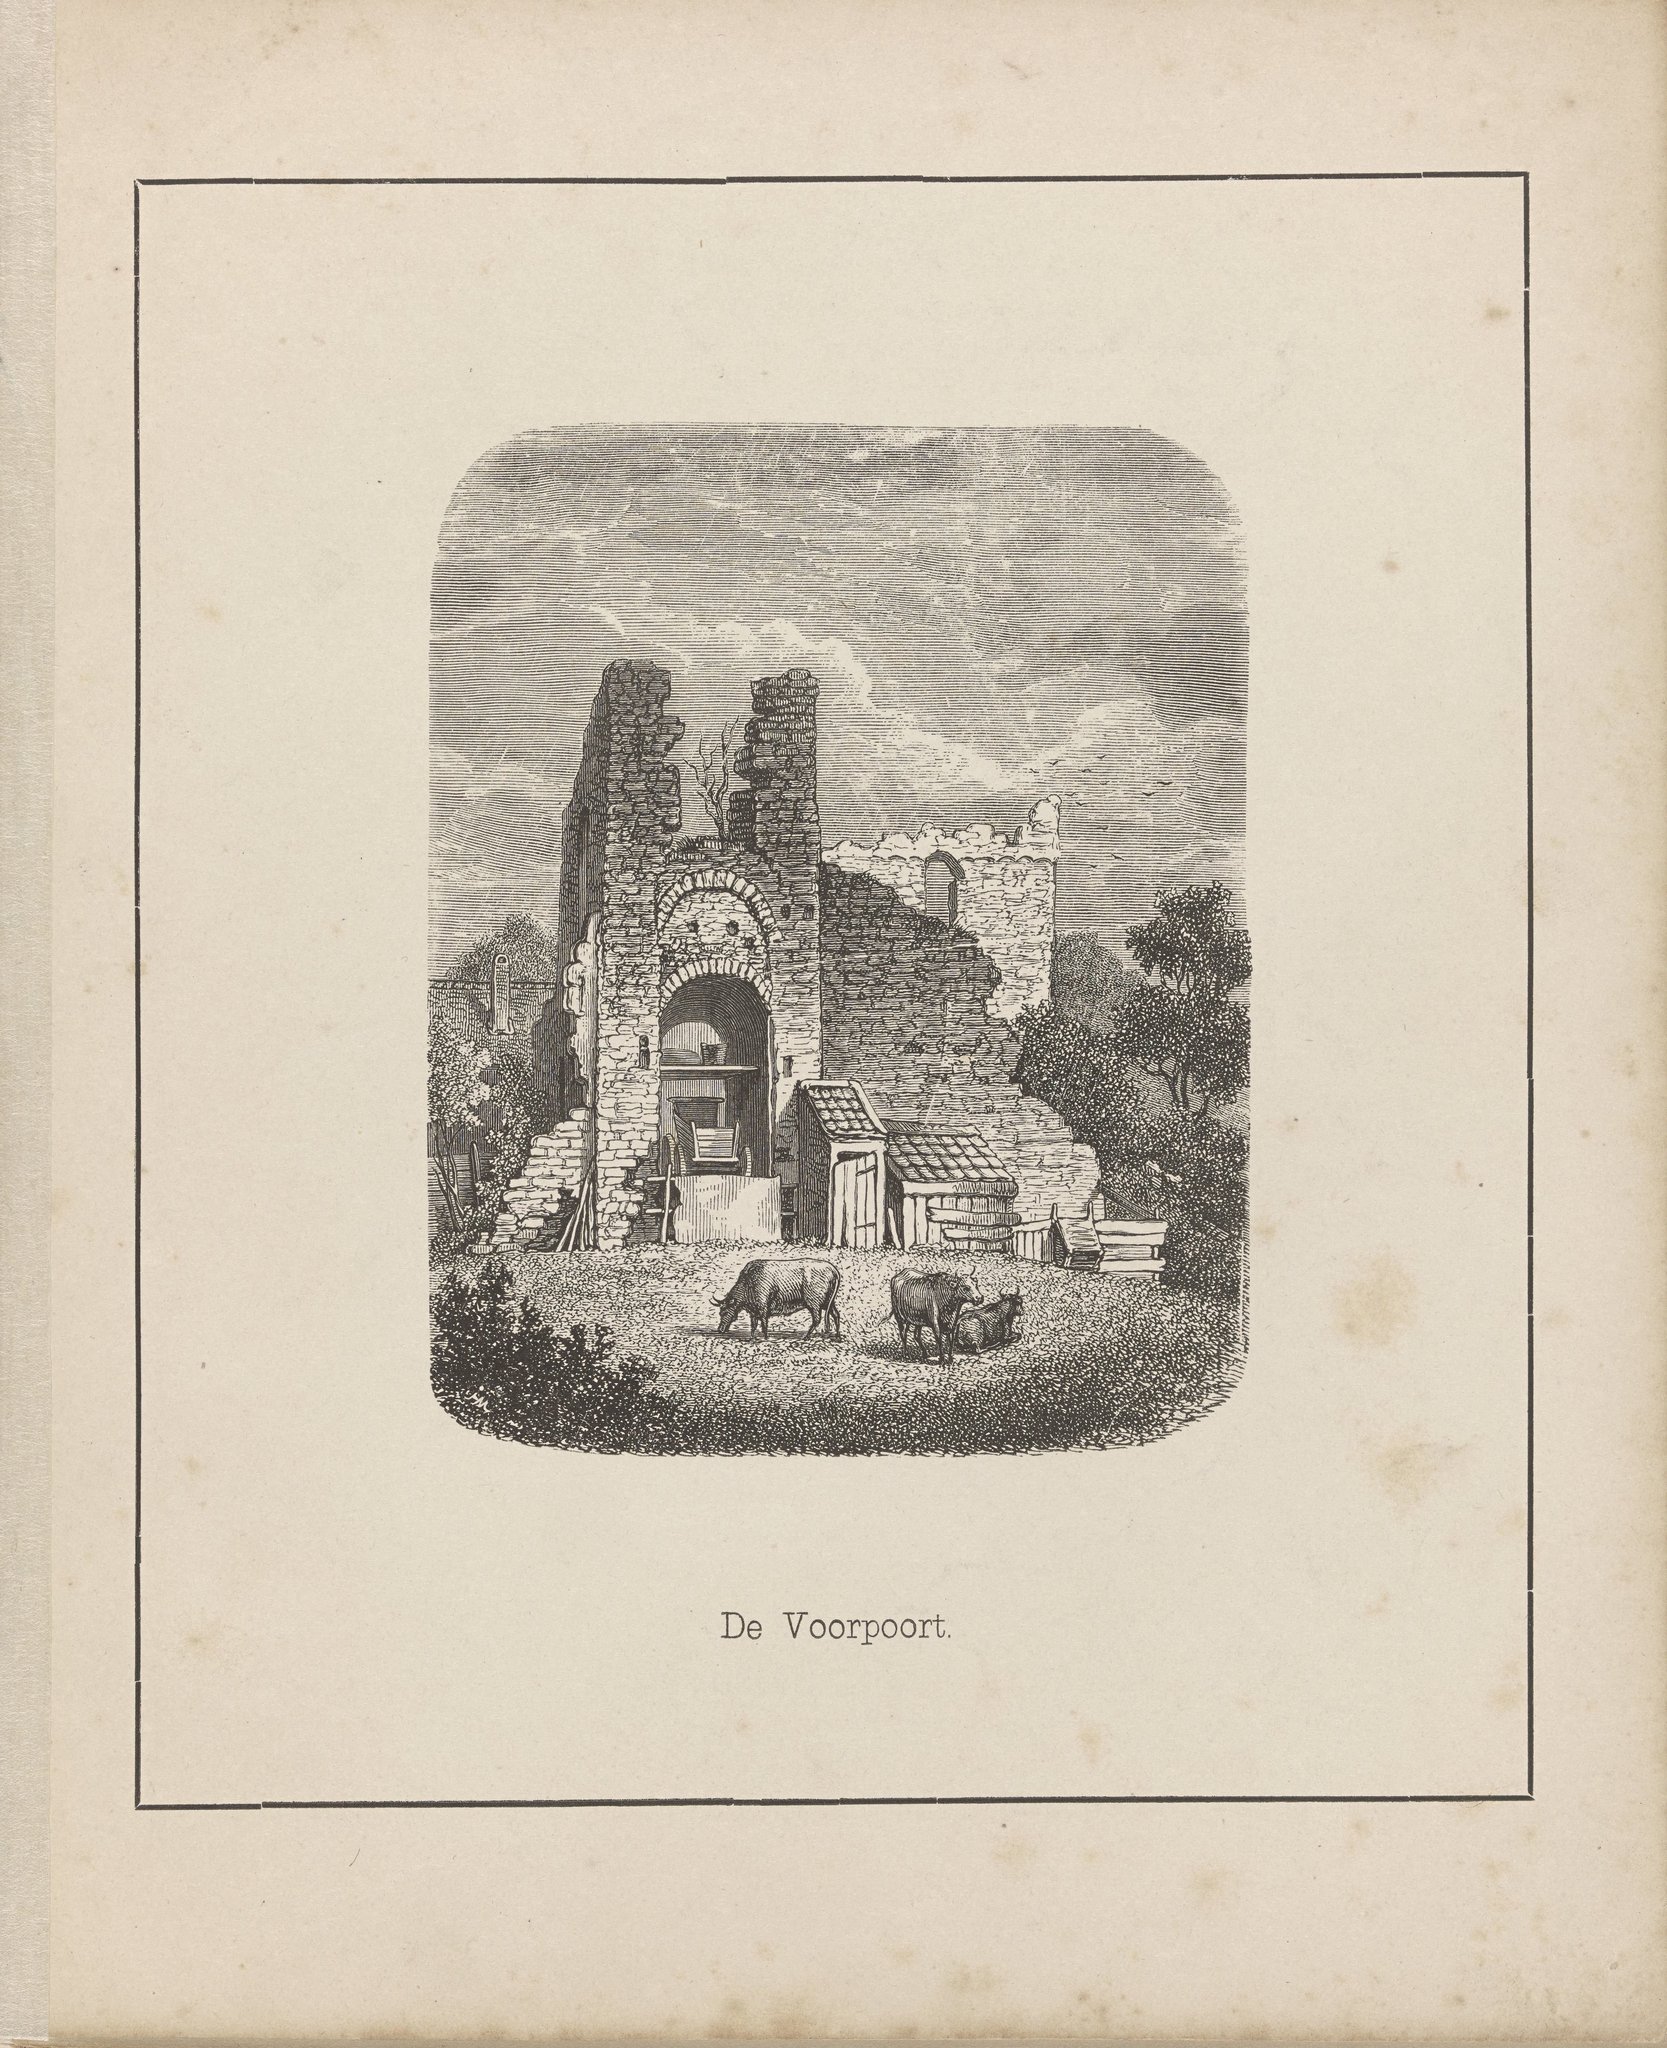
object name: book illustration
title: De voorpoort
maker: isaac weissenbruch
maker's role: print maker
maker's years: 1826-1912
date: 1861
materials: paper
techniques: letterpress printing, engraving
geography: amsterdam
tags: gate, entrance, ruin of a dwelling, house, castle, etc.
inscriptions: collector's mark: Lugt 2228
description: Prent uit: Hofdijk, Willem Jacob. Het kasteel en de edelen van Brederode. Amsterdam: Gebr. van Es, 1861.